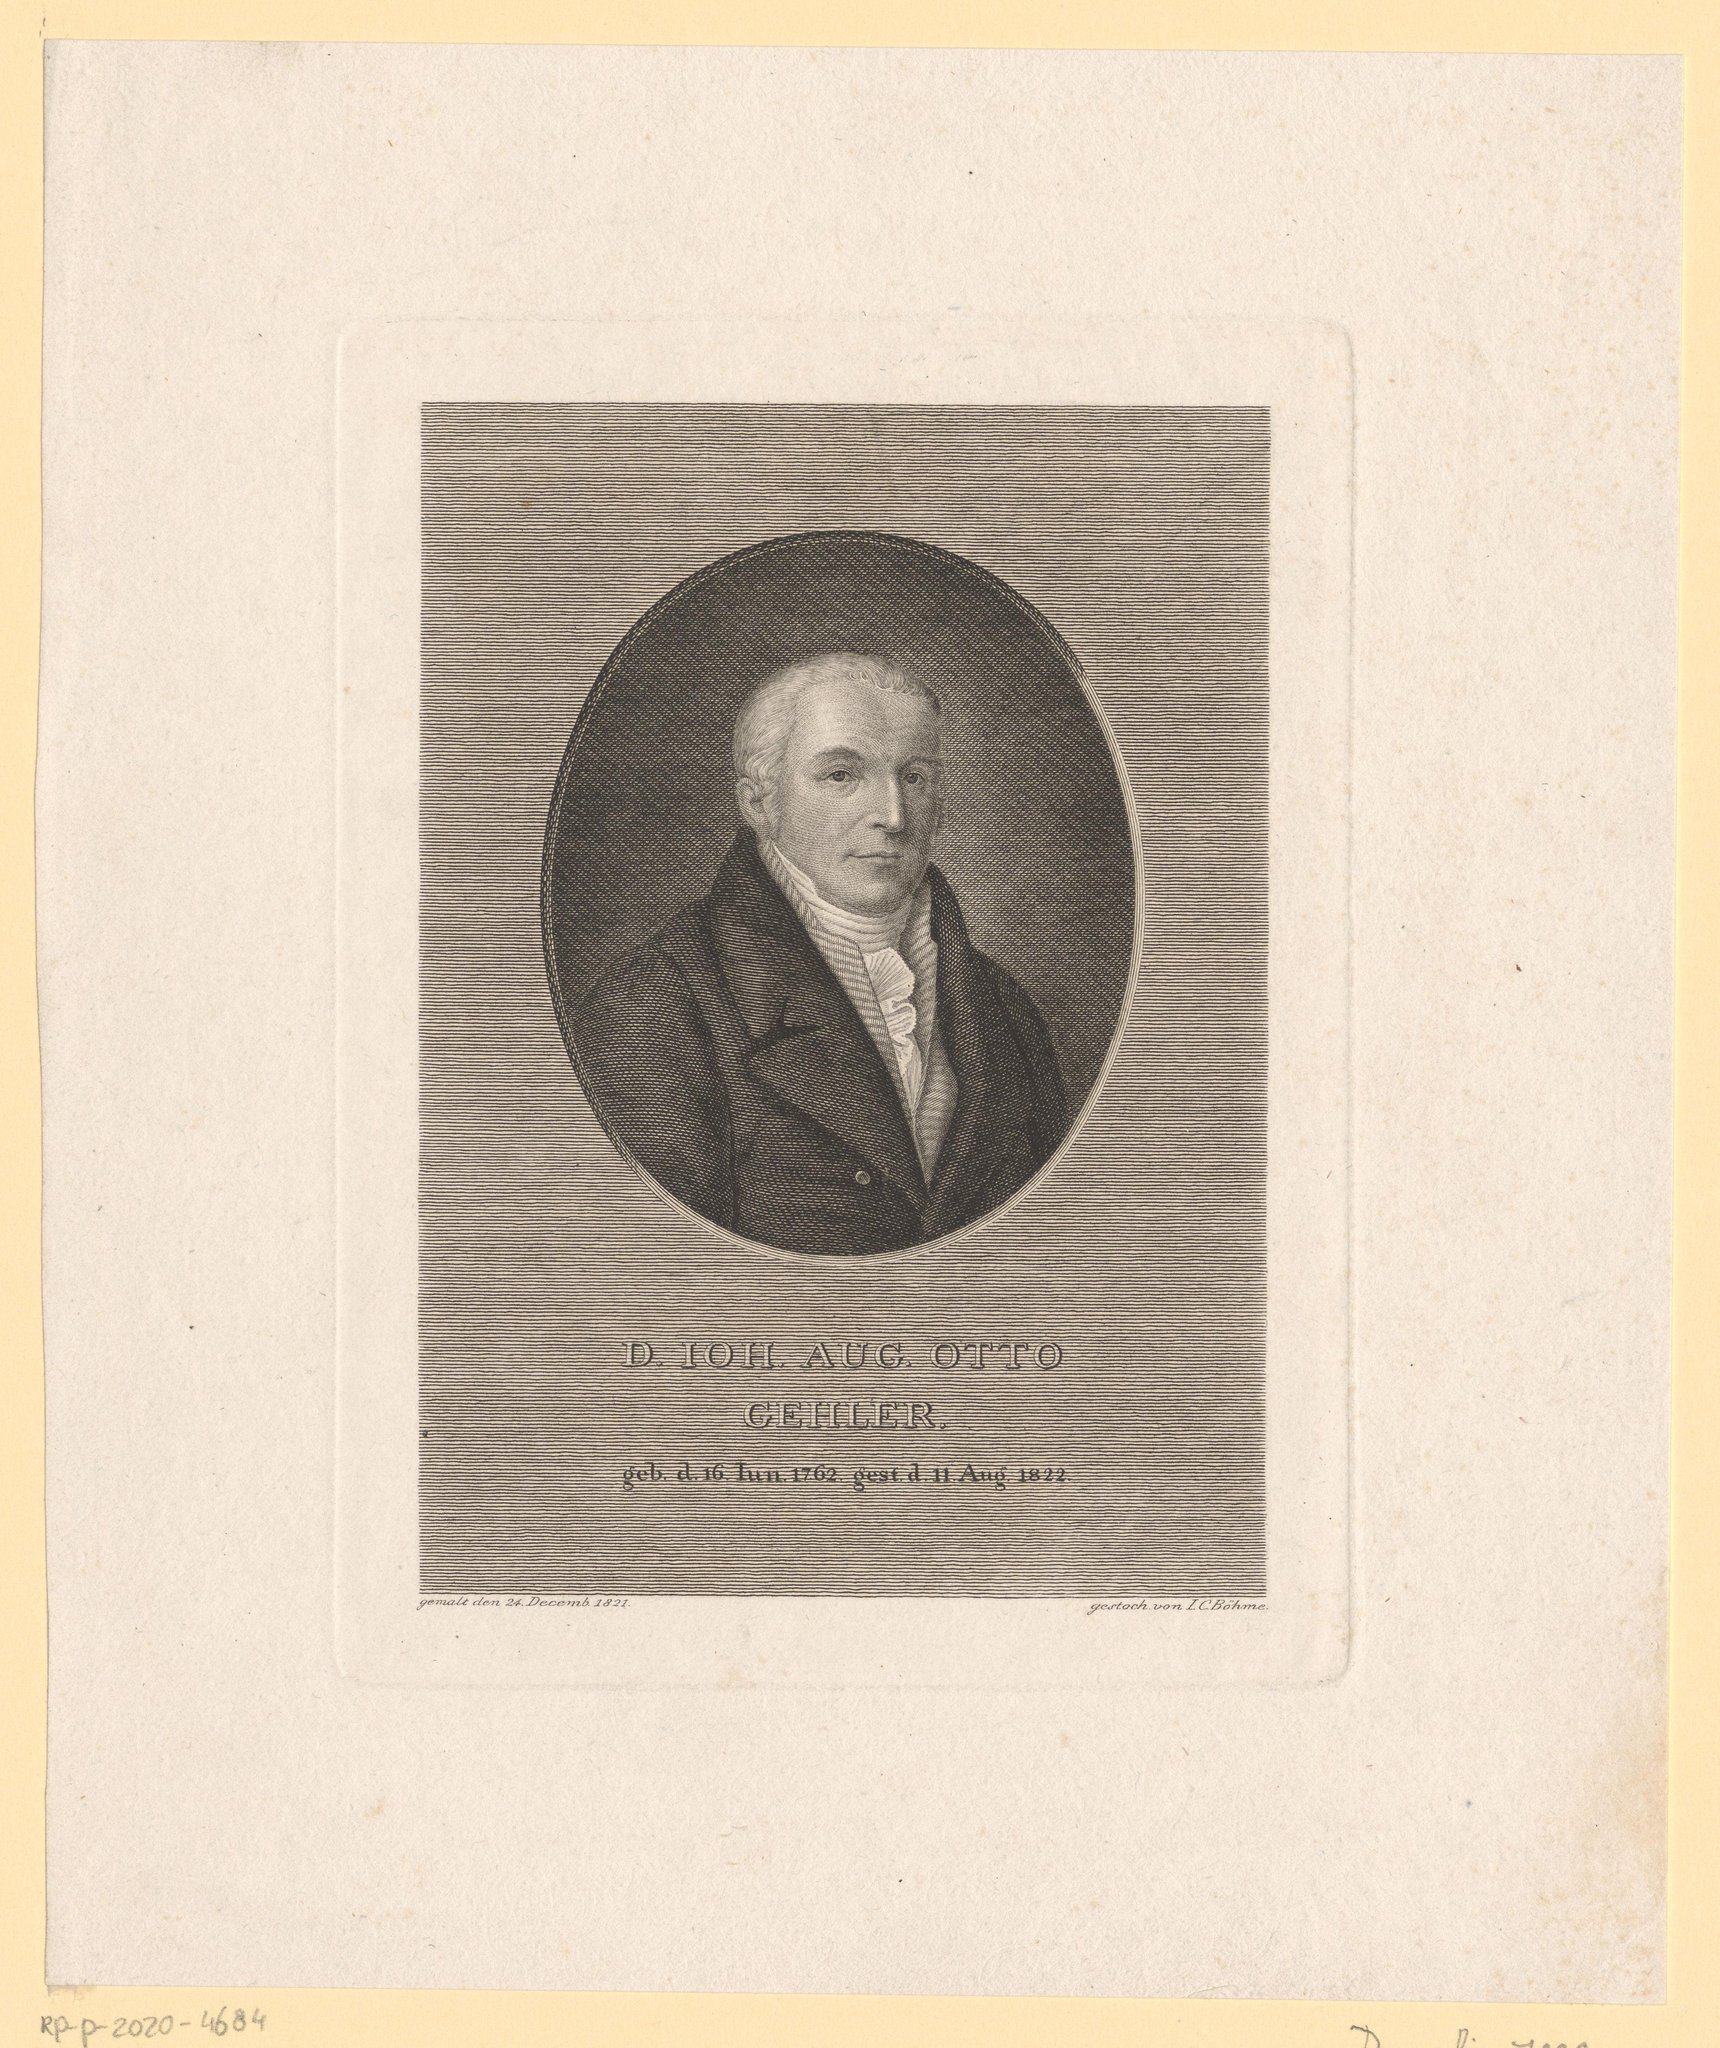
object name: print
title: Portret van Johann August Otto Gehler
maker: johann christiaan böhme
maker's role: print maker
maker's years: 1771-1835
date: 1822-1835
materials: paper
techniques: engraving, etching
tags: historical persons, lawyer, attorney at law